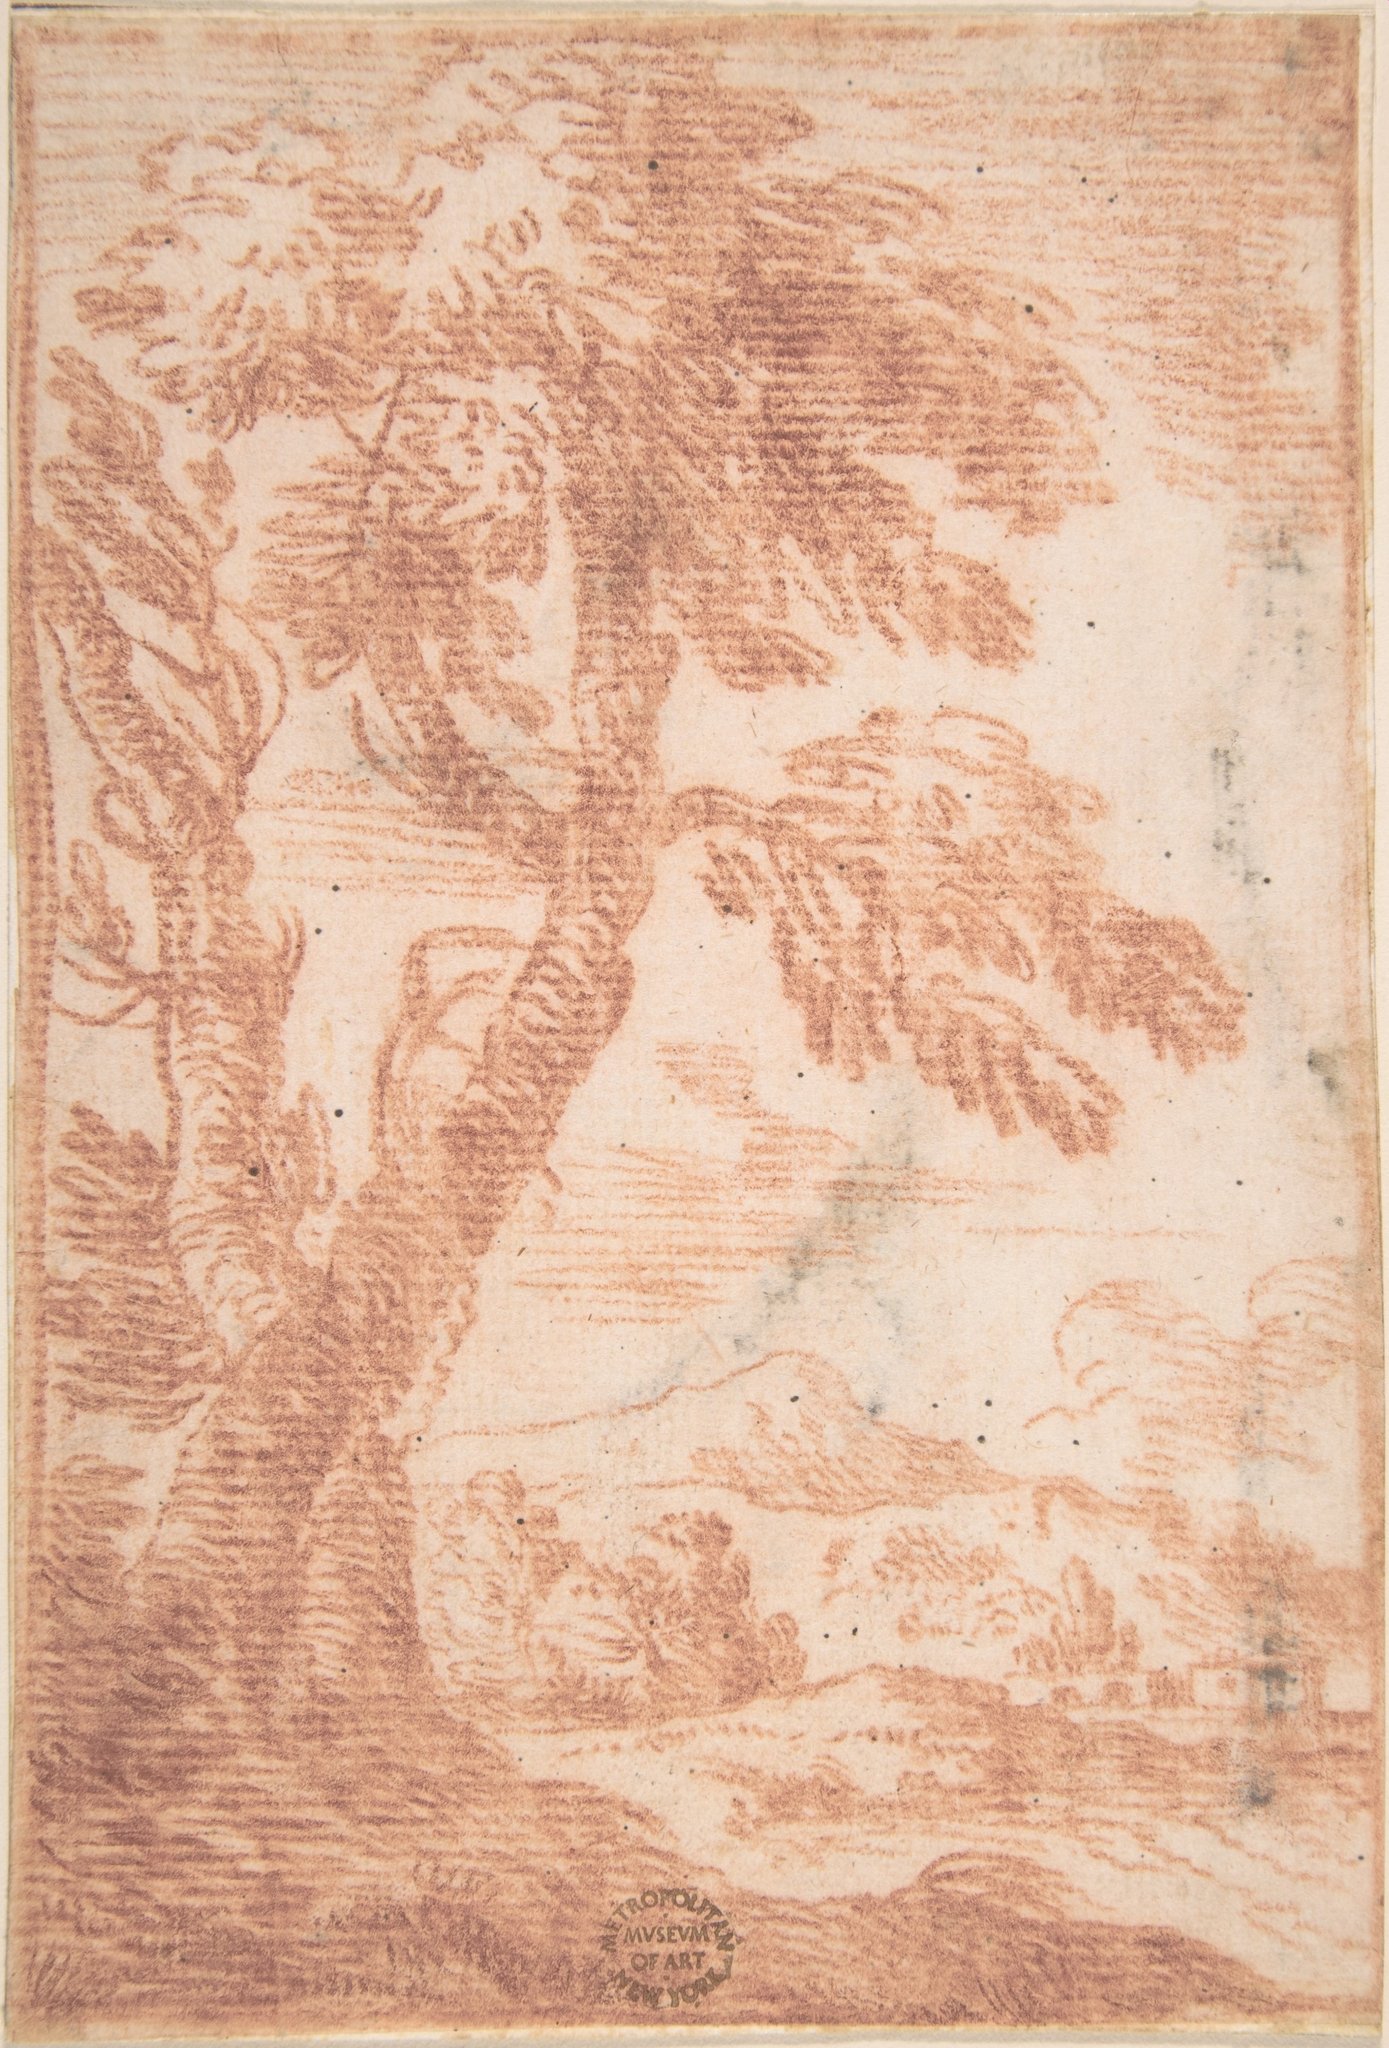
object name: drawing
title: Distant Landscape with Tree in Foreground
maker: aureliano milani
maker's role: artist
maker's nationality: italian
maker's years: 1675-1749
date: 1601-1700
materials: chalk, paper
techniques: printmaking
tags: landscapes,trees